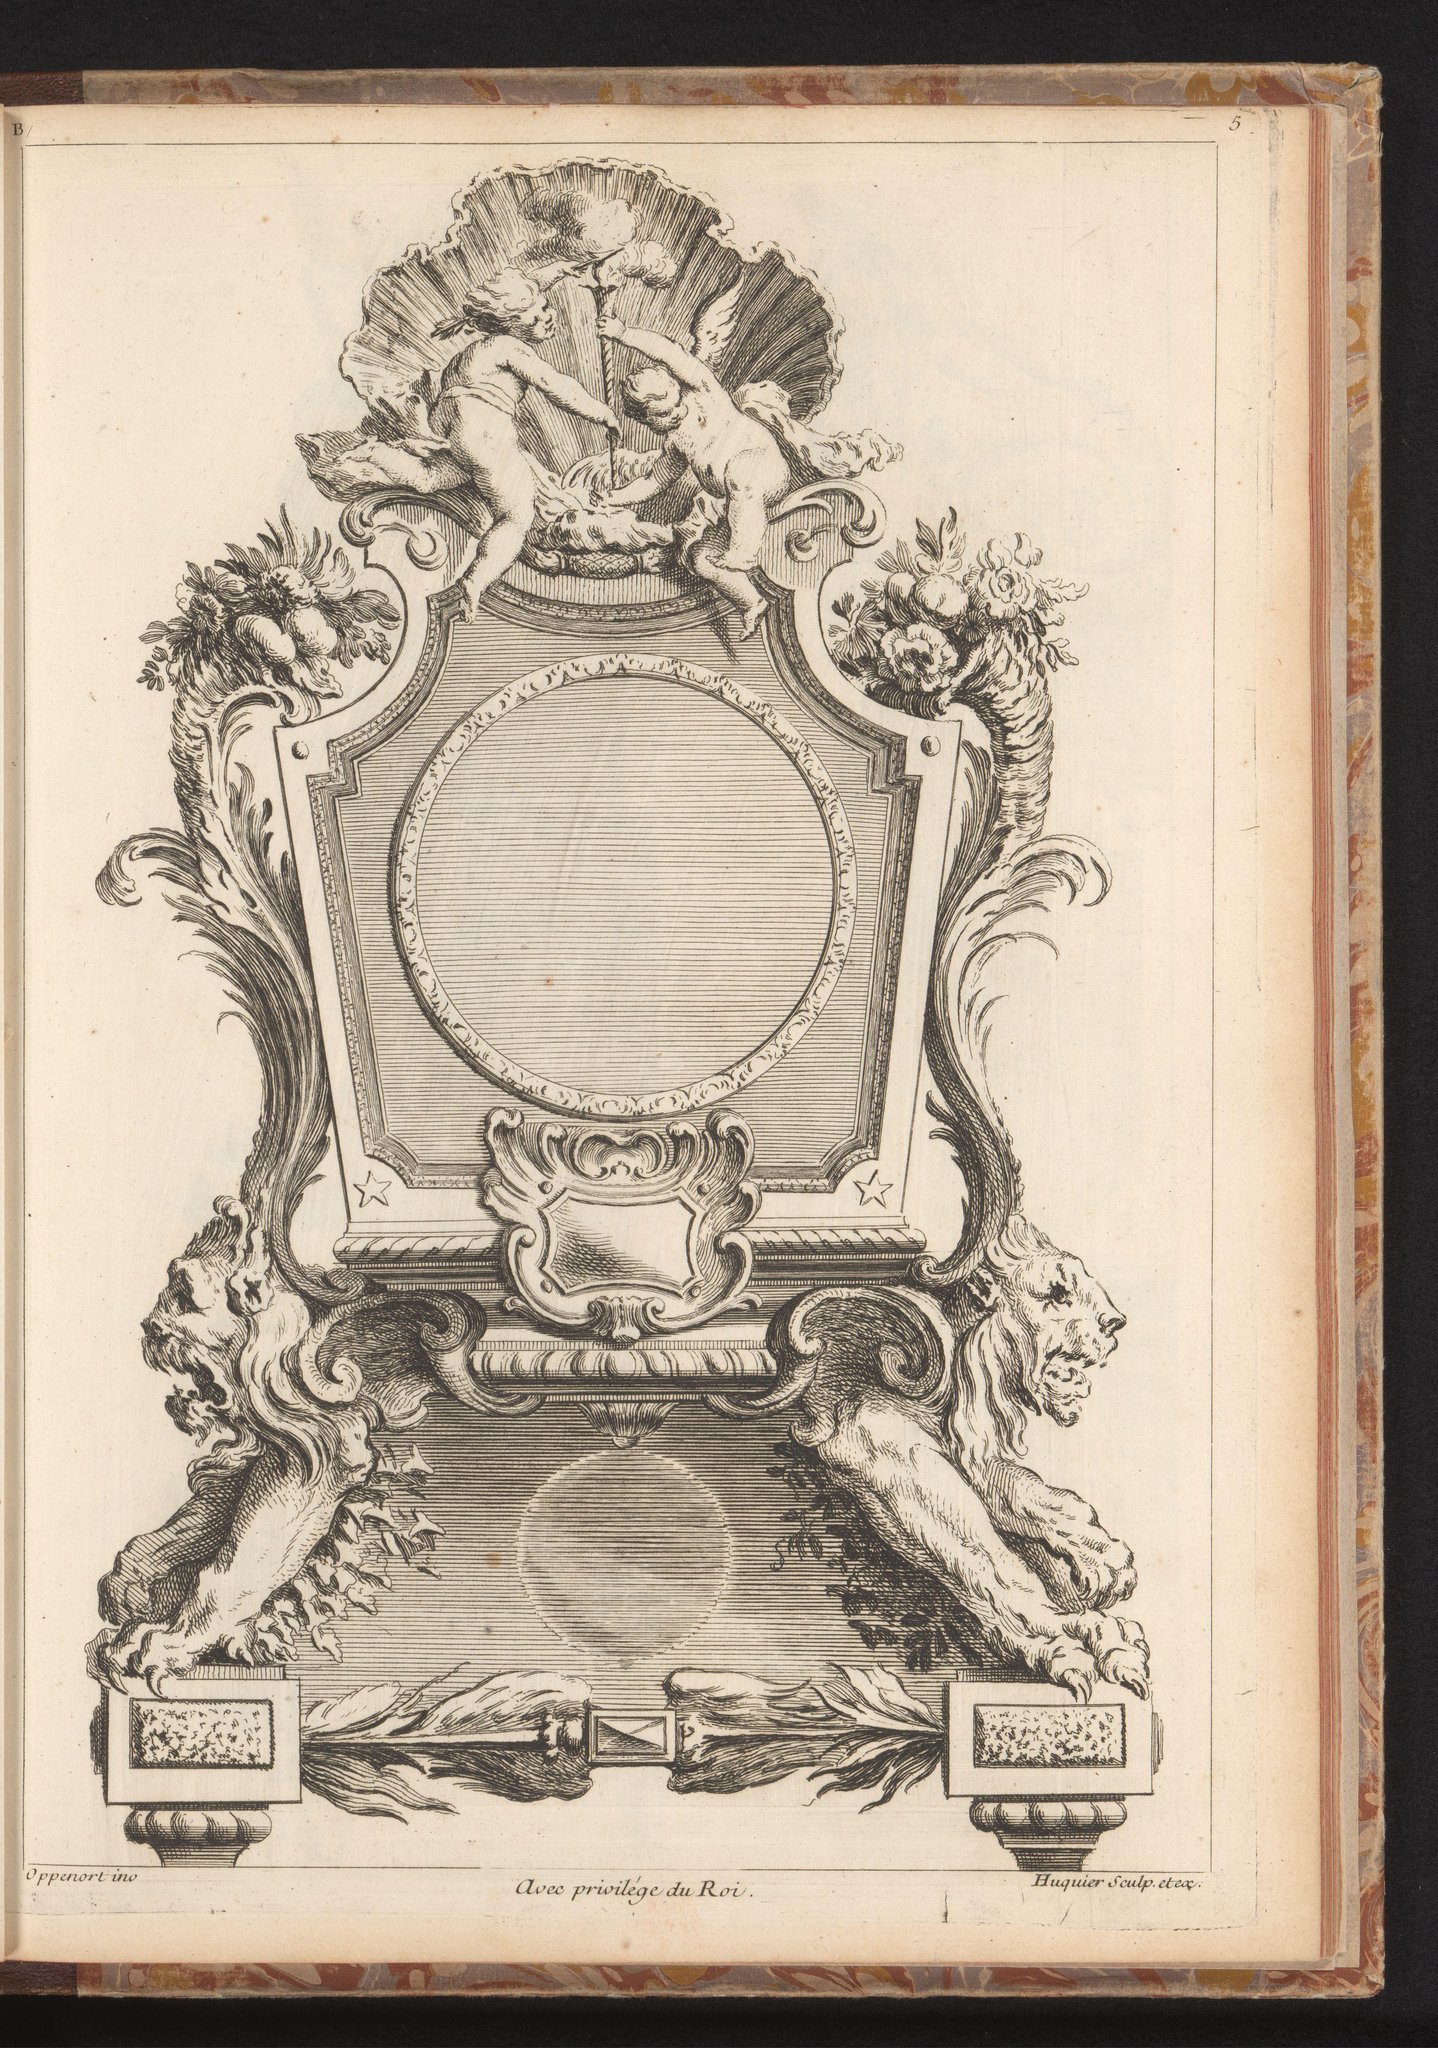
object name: ornament print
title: Second livre contenant differens desseins de pendules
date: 1725-1750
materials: paper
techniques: etching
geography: paris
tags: lion's head ~ ornament, ornaments ~ art, angel(s) with torch, clock, cupids: 'amores', 'amoretti', 'putti'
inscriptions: collector's mark: Lugt 2228a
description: Deze prent maakt deel uit van een album.